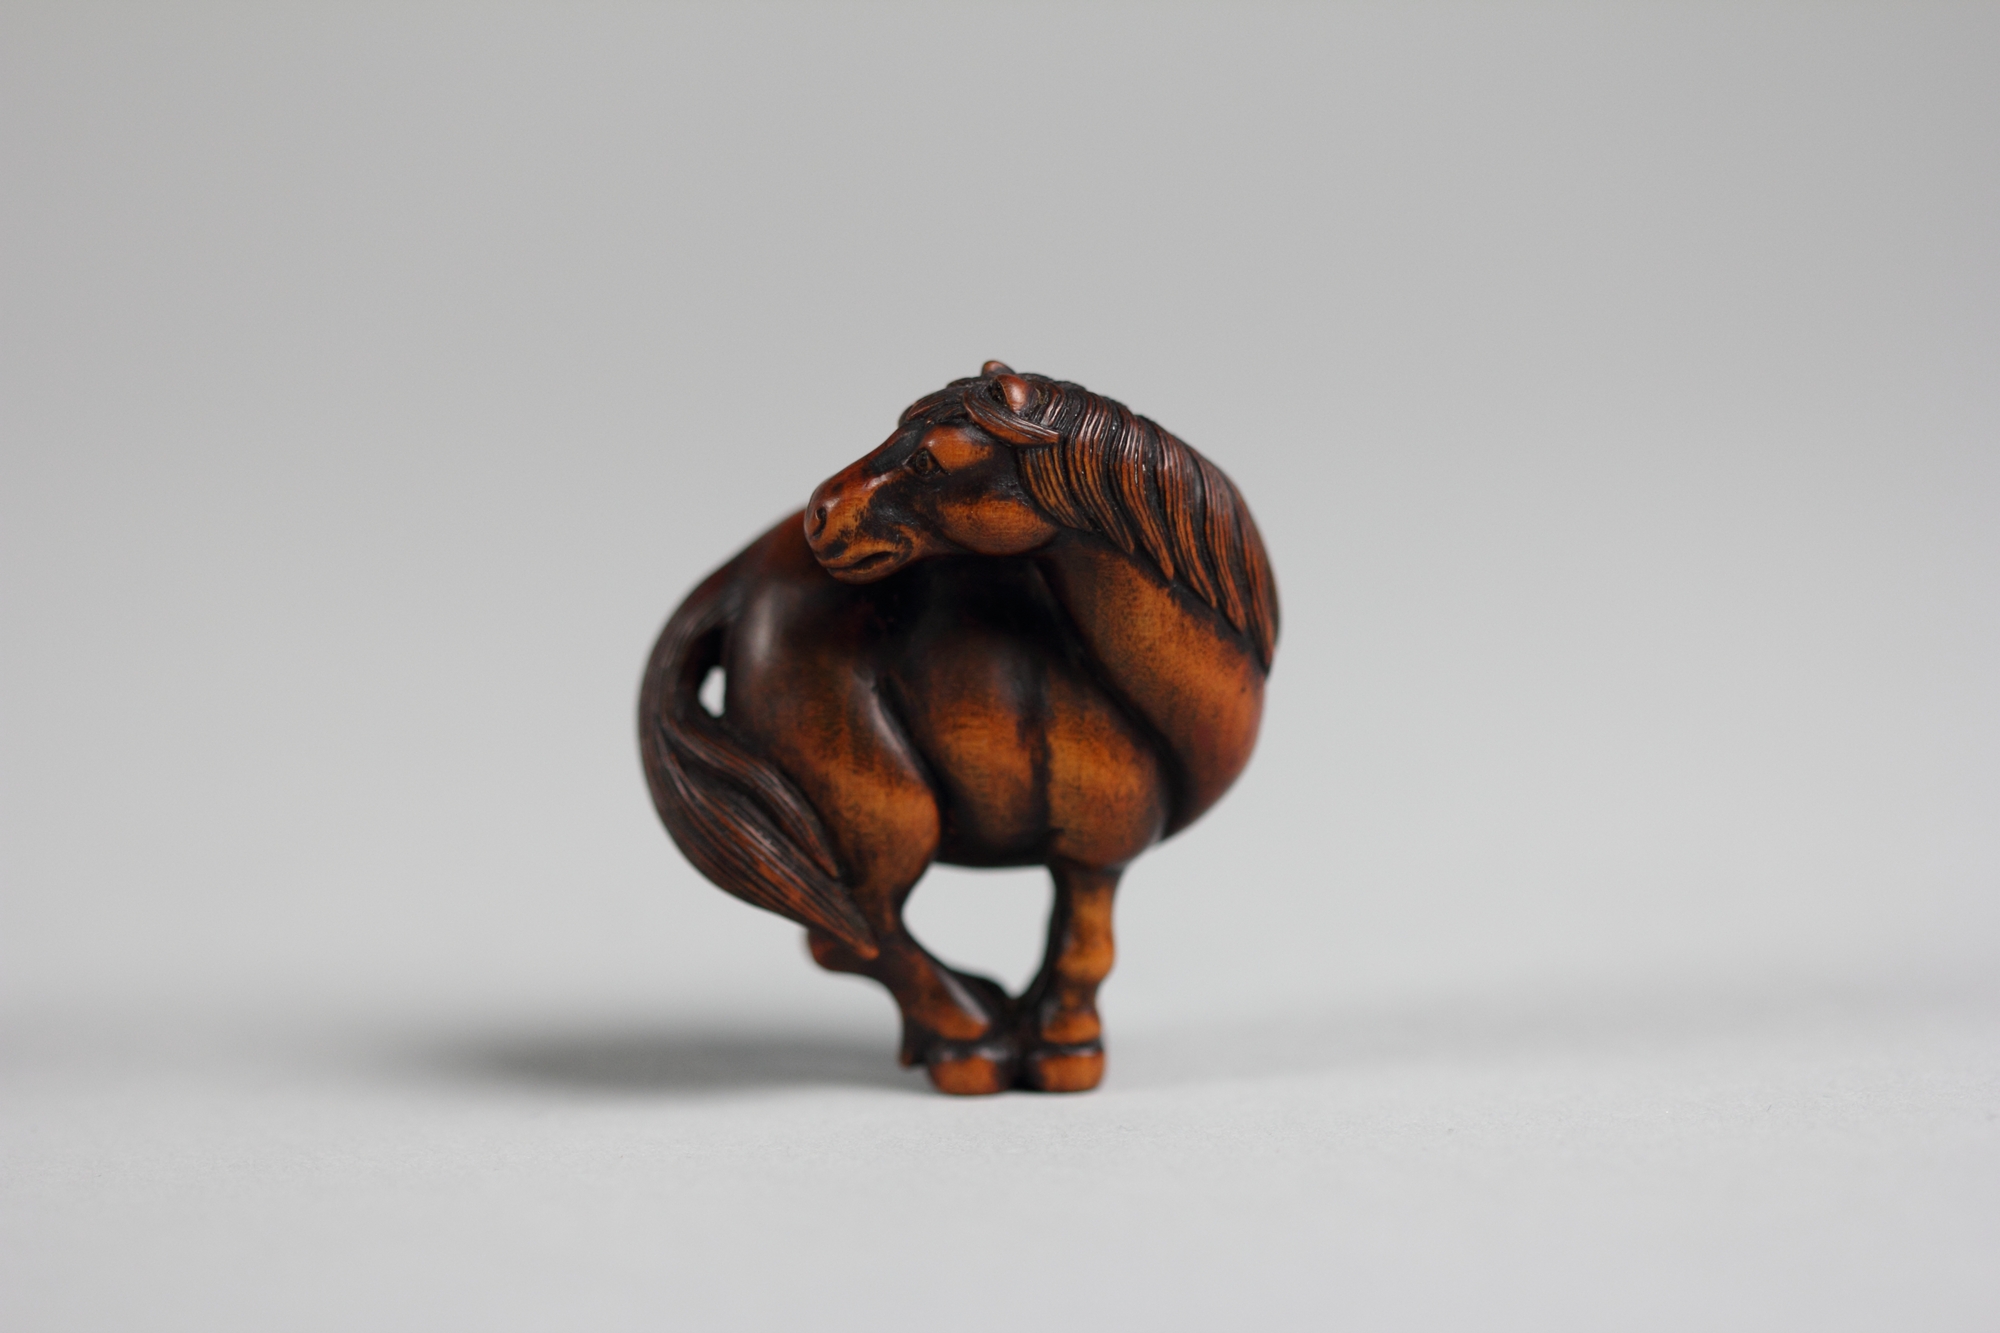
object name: netsuke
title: Netsuke of Horse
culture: japanese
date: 1801-1900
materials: wood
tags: horses